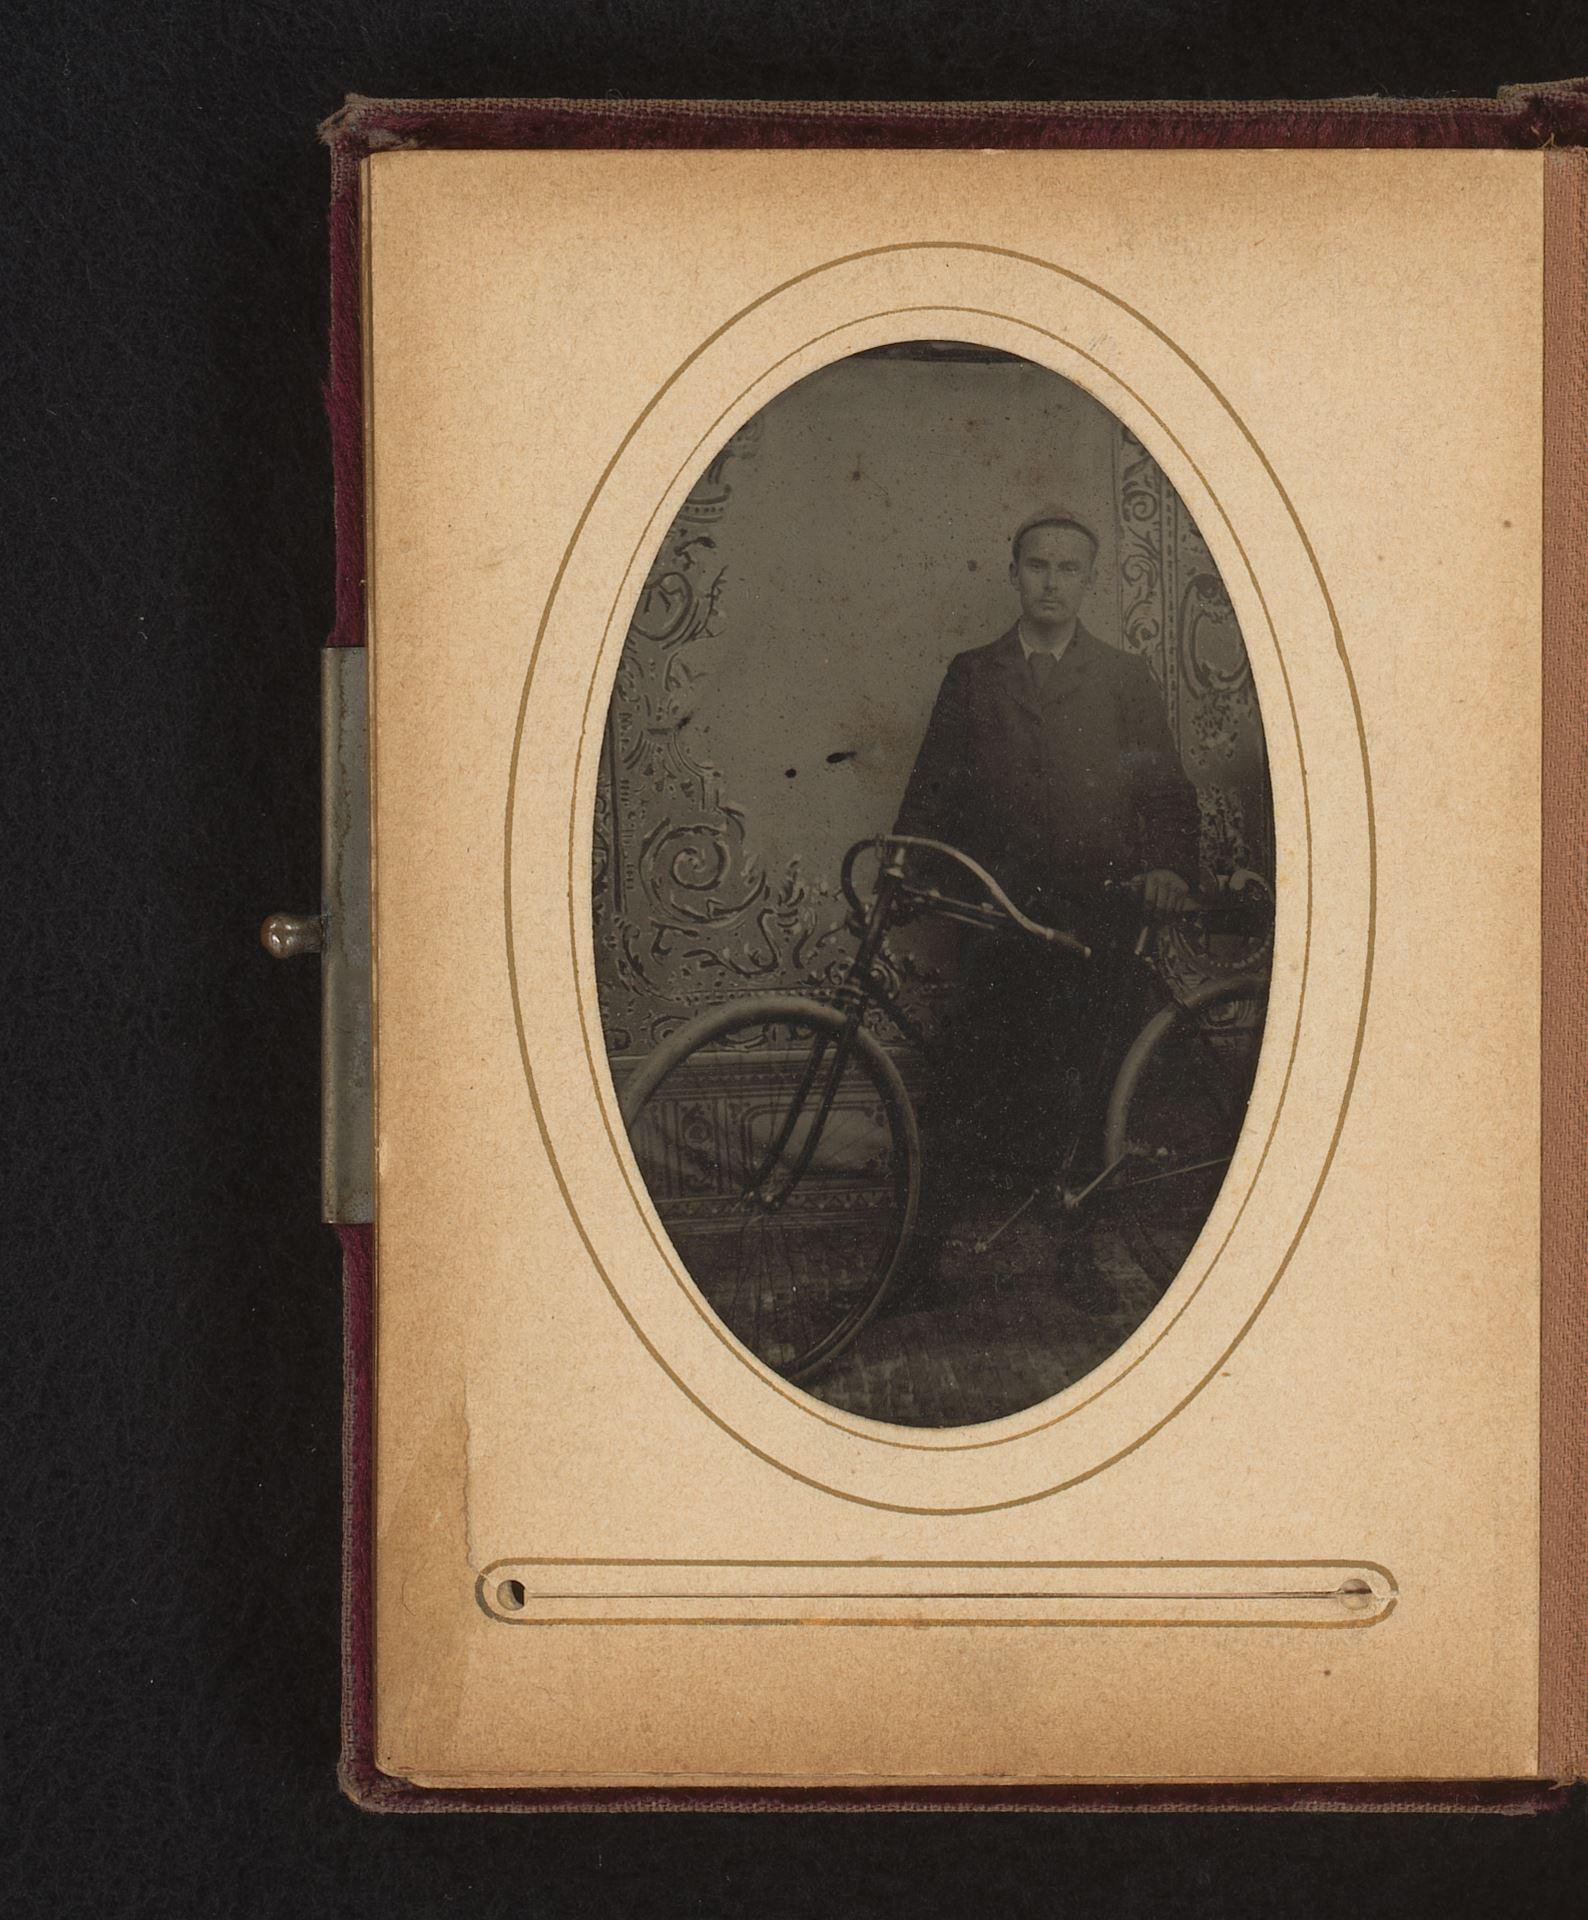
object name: photograph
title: Portret van een man met een fiets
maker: Anonymous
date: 1870-1882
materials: iron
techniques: ferrotyping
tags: adult man, historical persons, bicycle